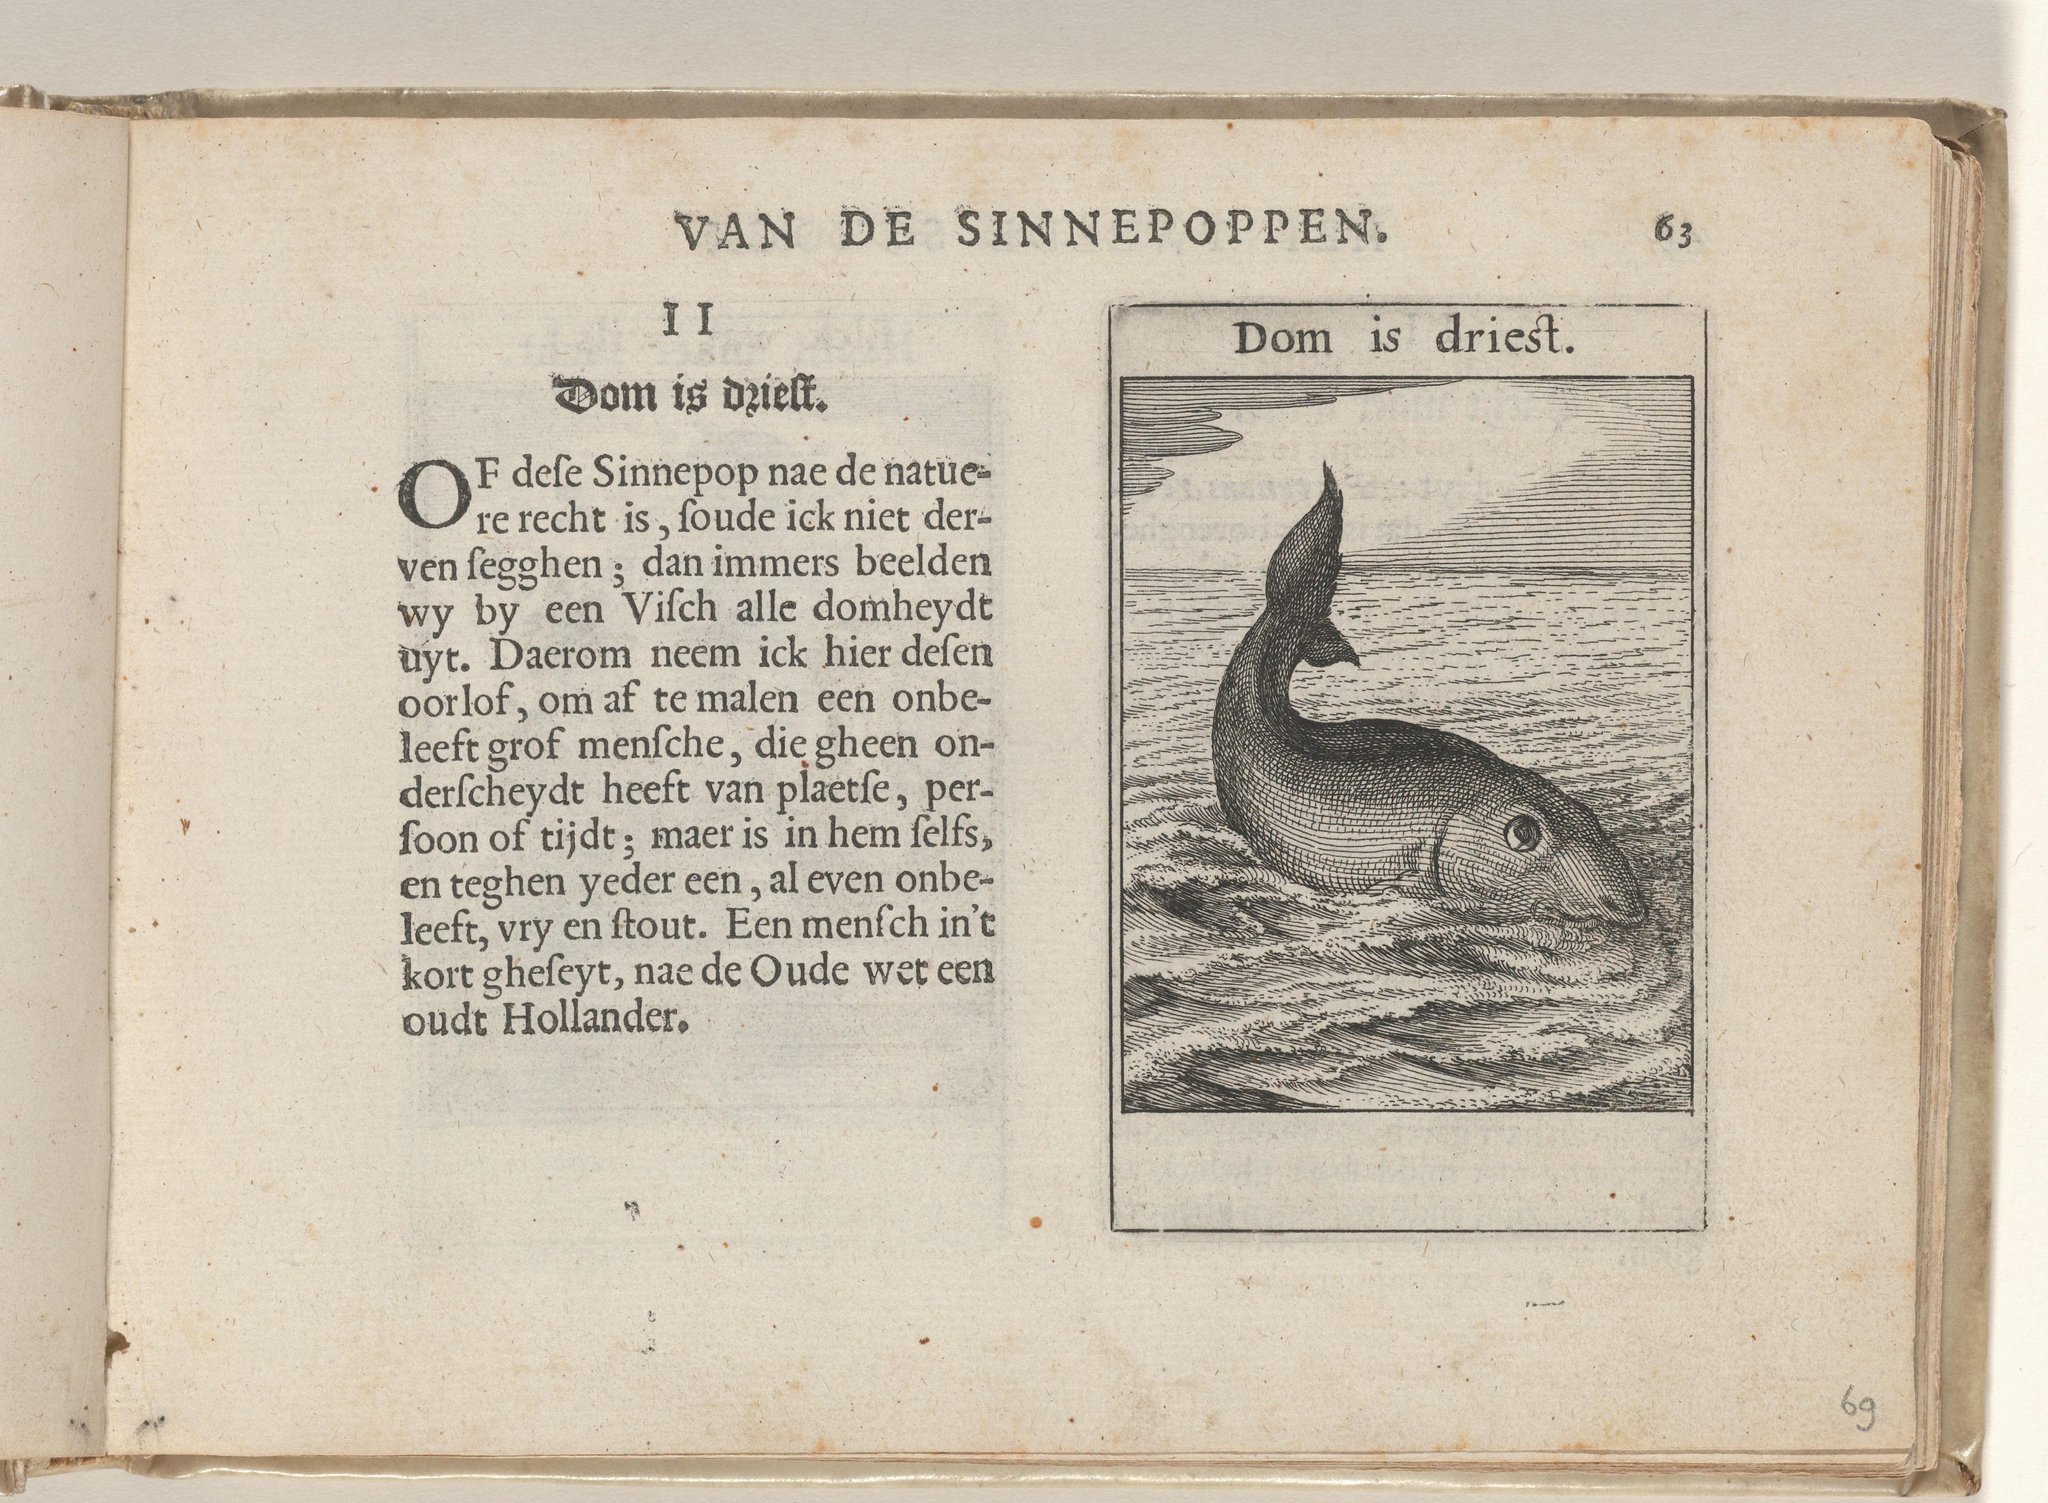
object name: album leaf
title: II Dom is driest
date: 1614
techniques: engraving, printing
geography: the hague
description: II Dom is driest. Tweede schok. Onderdeel van 'Sinnepoppen', R. Visscher, 1614.